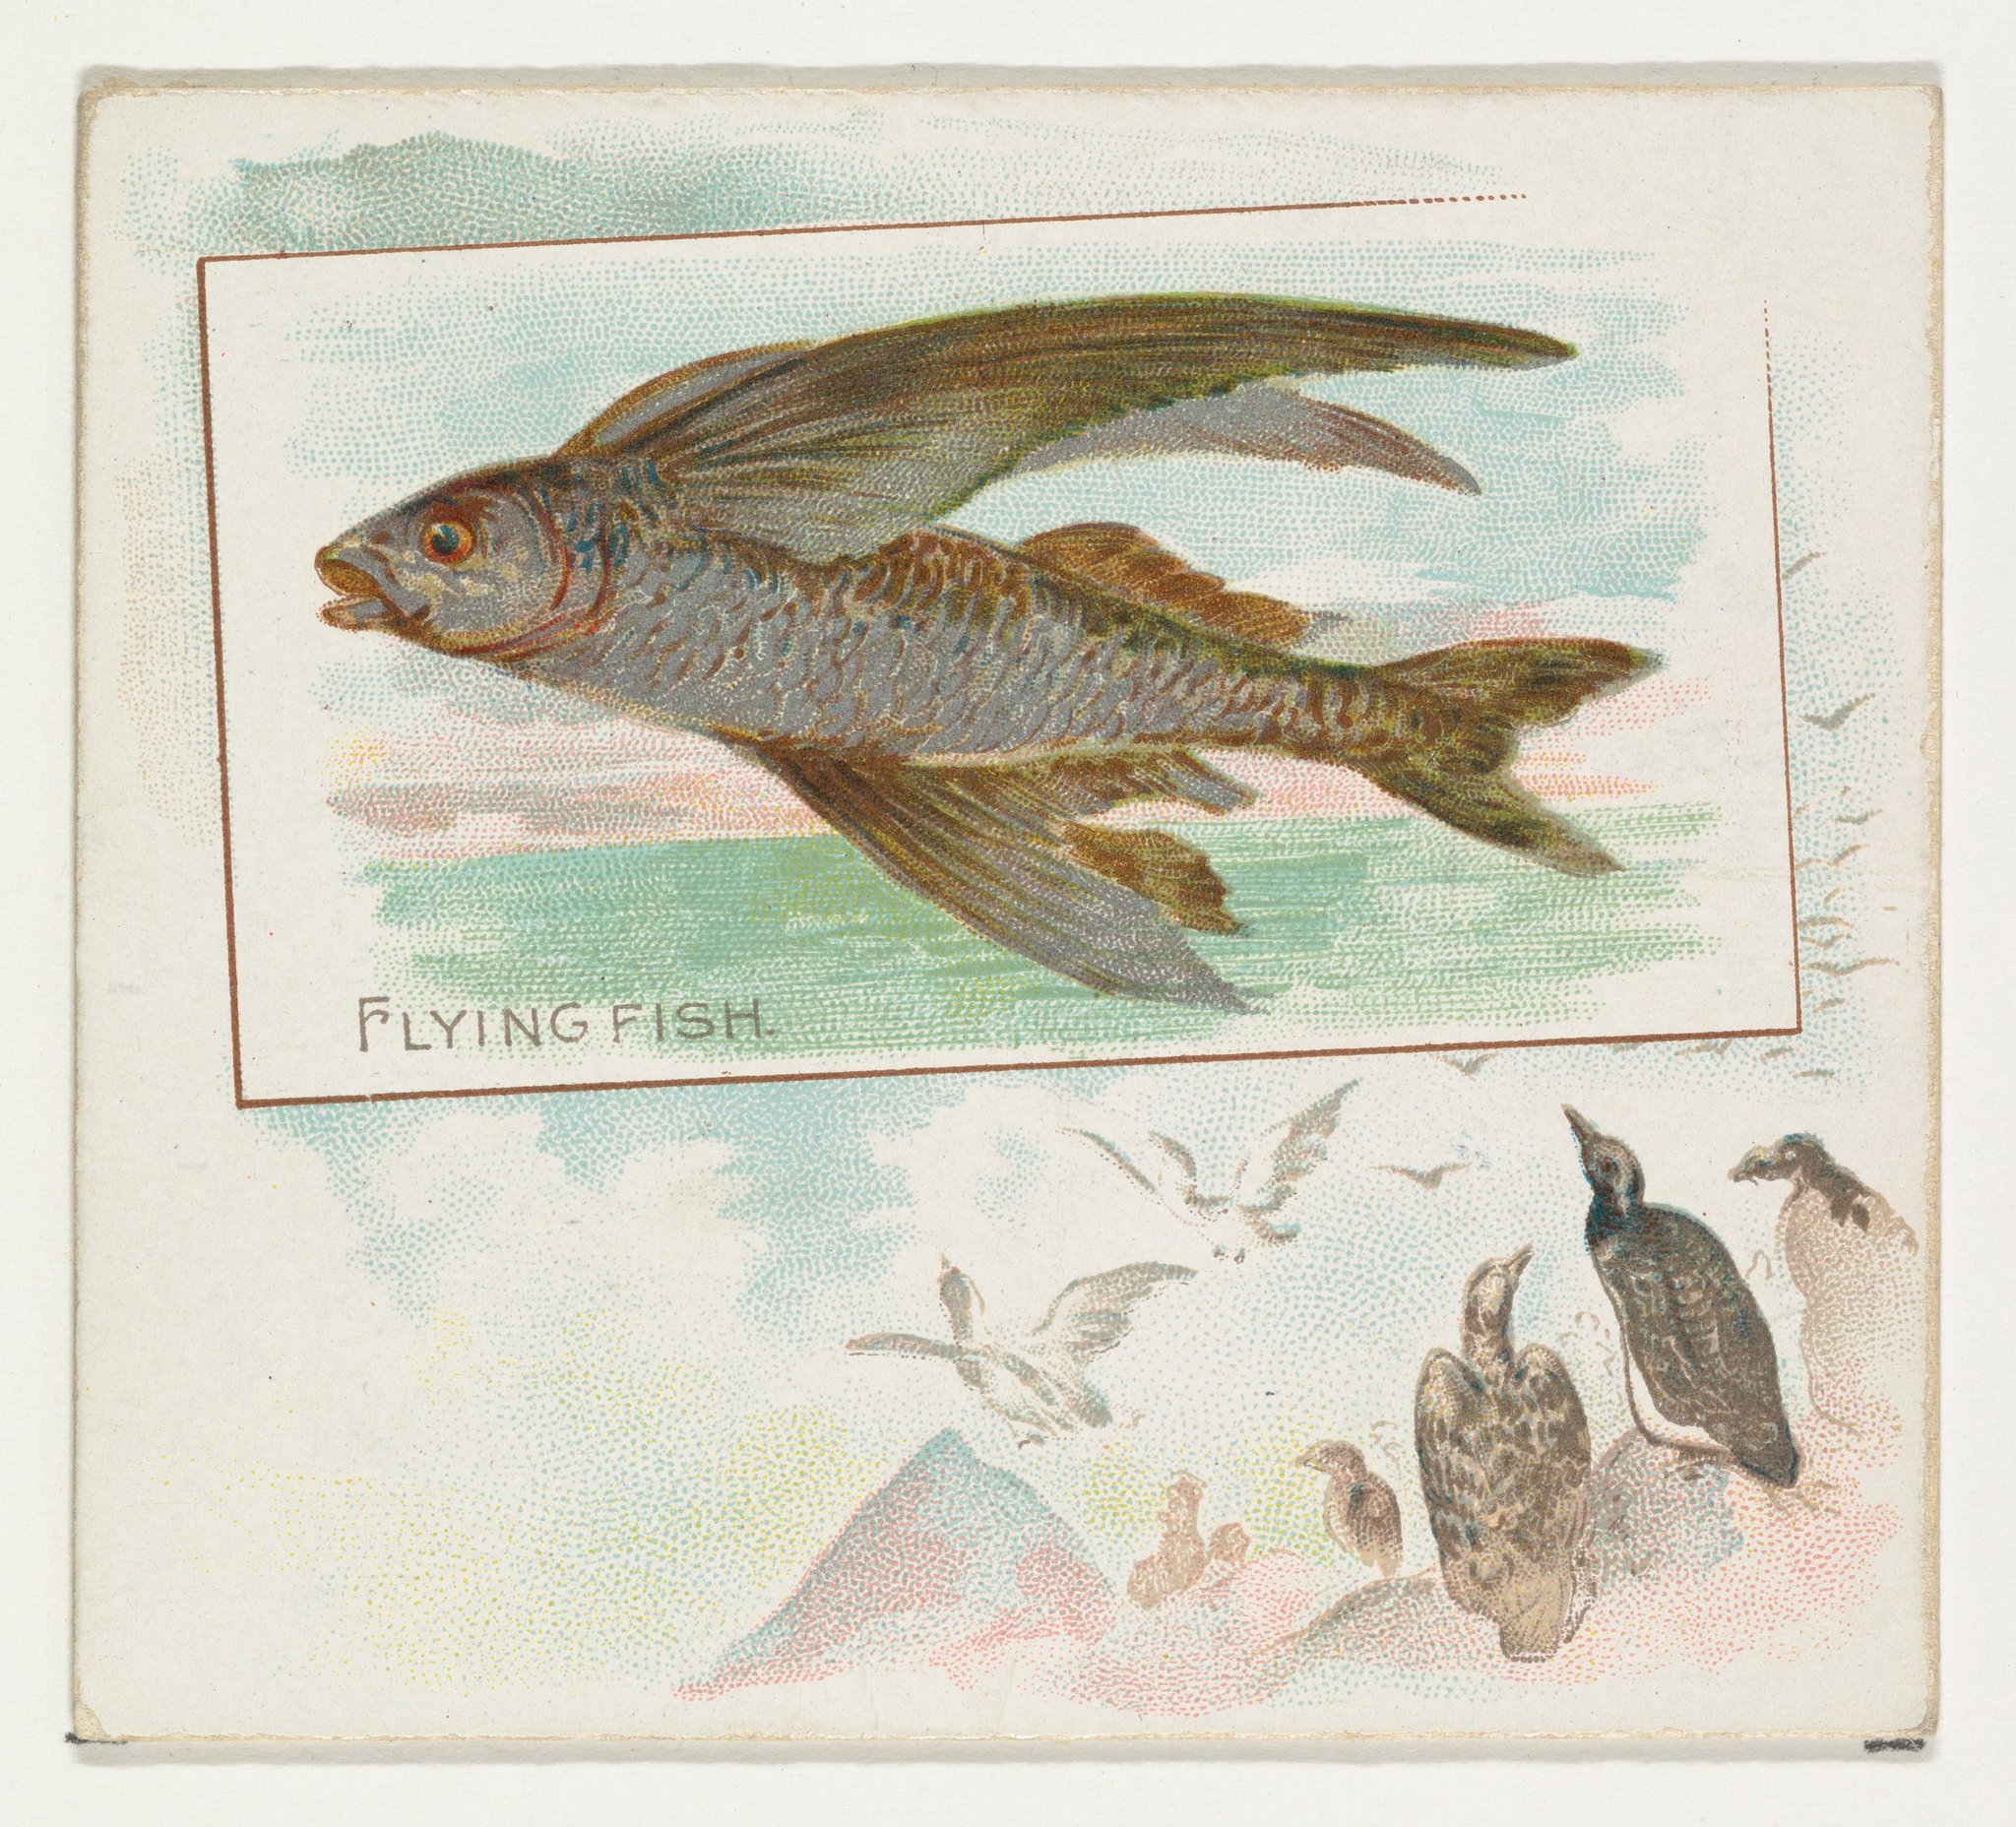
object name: print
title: Flying Fish, from Fish from American Waters series (N39) for Allen & Ginter Cigarettes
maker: allen & ginter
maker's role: publisher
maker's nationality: american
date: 1889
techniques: color lithograph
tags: fish